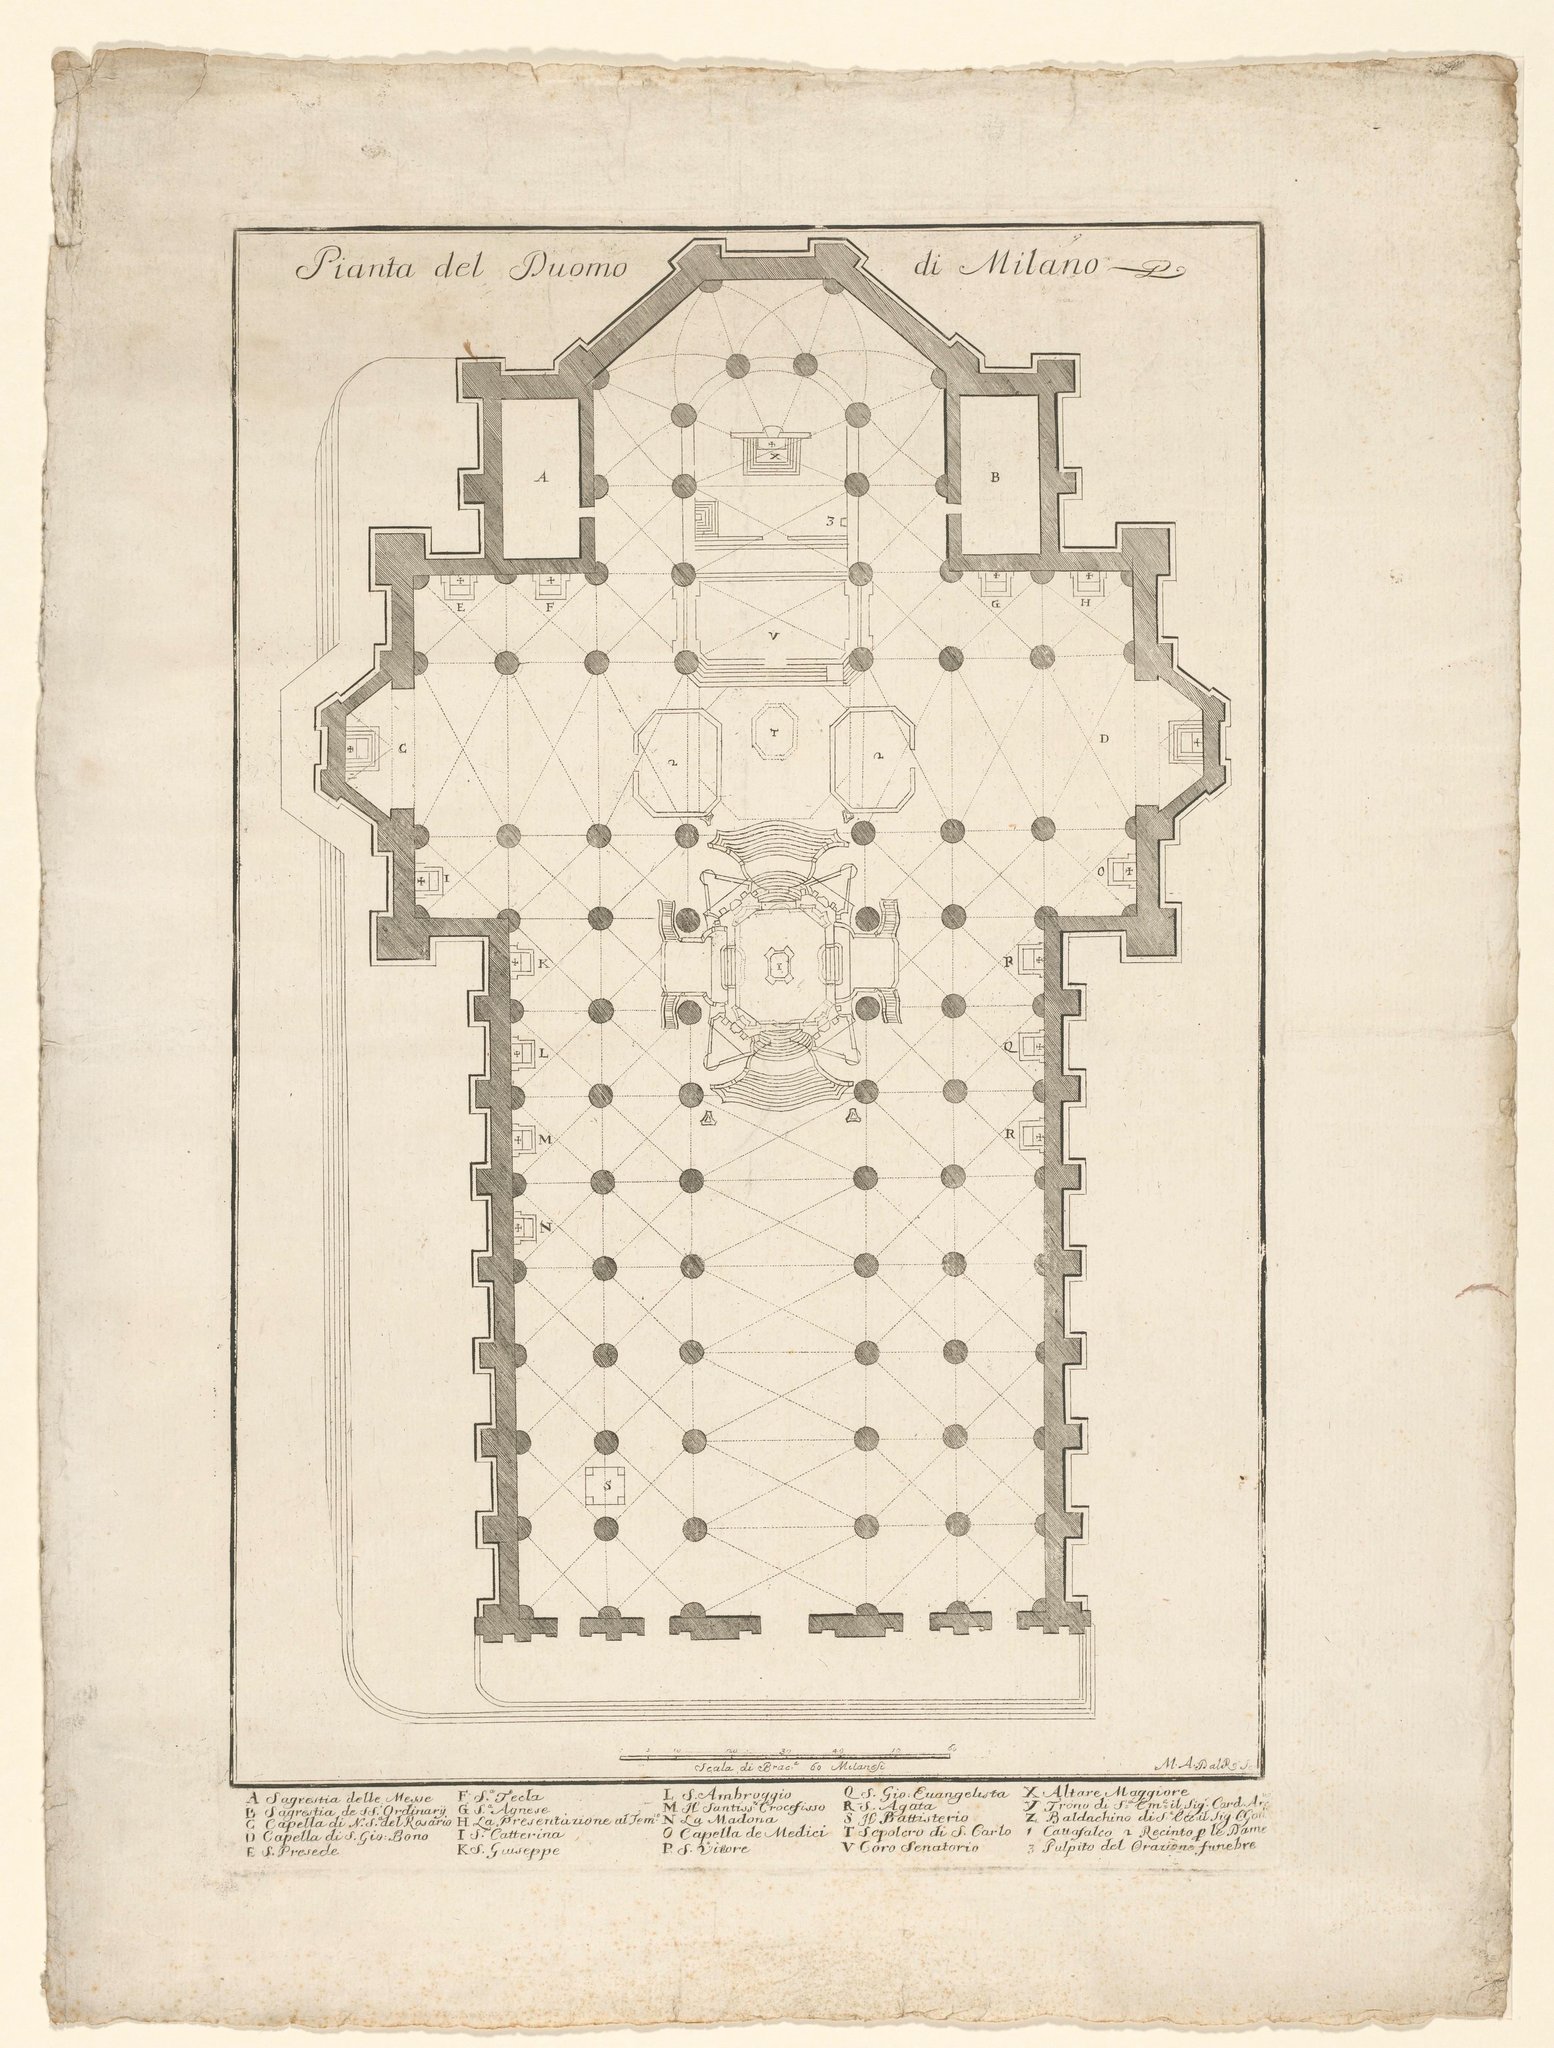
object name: print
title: Plattegrond van de Dom van Milaan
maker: marc antonio dal re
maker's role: print maker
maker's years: 1697-1766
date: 1723-1766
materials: paper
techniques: etching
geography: milan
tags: interior of church, plan ~ architecture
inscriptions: collector's mark: Lugt 2228